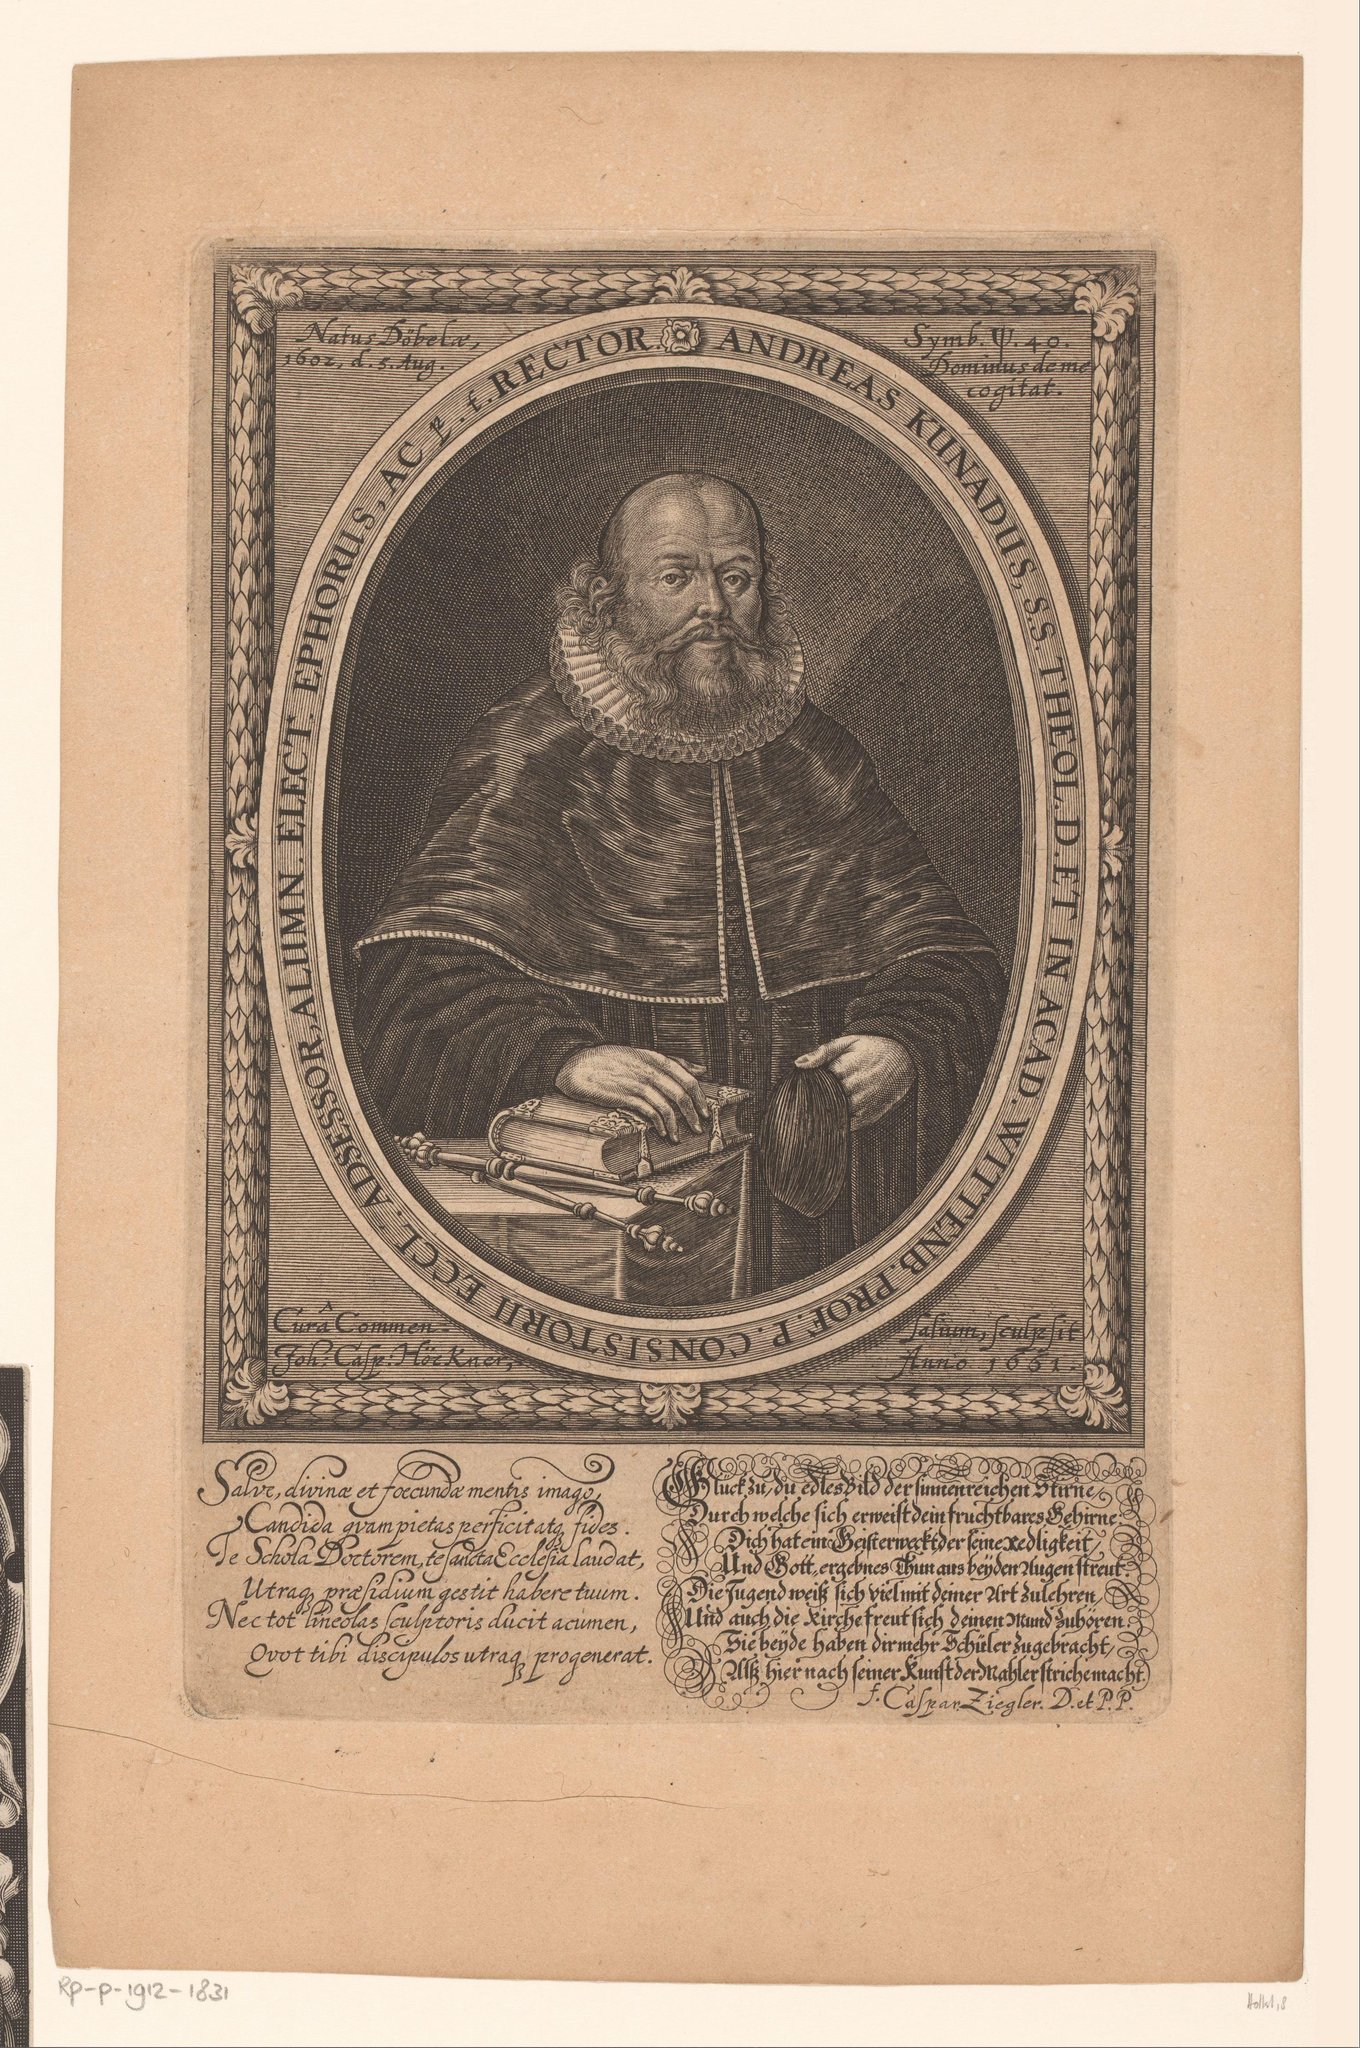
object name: print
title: Portret van Andreas Kunad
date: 1661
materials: paper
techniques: engraving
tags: theologian, historical persons, book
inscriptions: collector's mark: Lugt 2228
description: Met onderschrift in het Latijn en Duits.